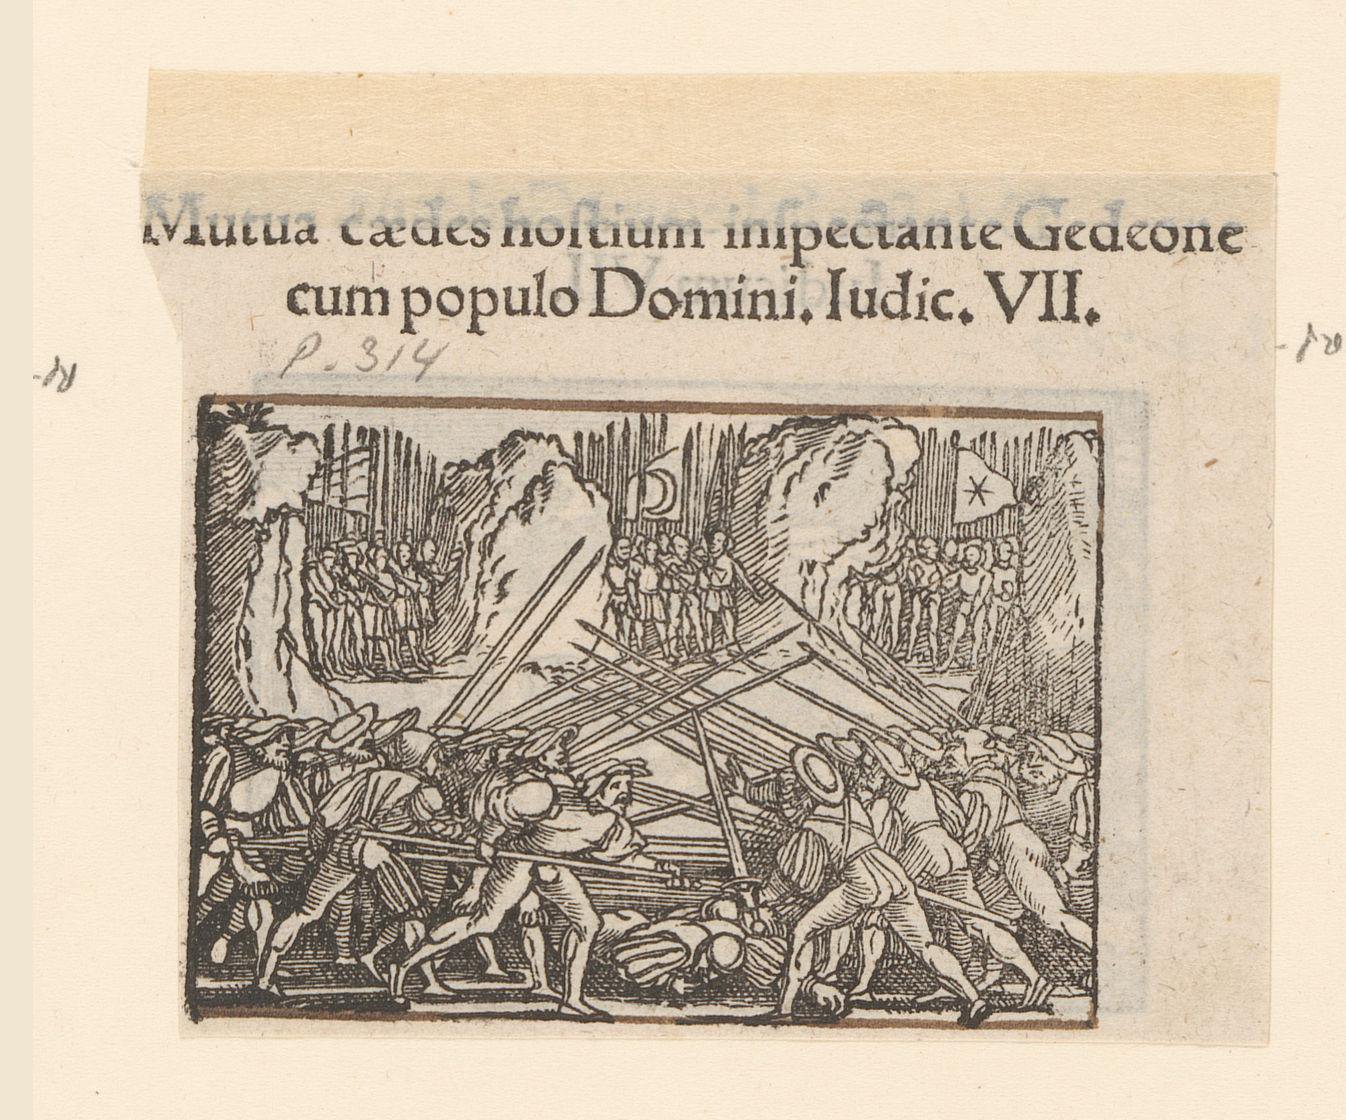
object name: book illustration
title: Gideons manschappen verslaan de Midianieten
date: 1530-1533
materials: paper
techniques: woodcut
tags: gideon and his army attack the midianites (judges 7:9-25)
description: Prent afkomstig uit: Biblicae historiae. Frankfurt am Main: Egenloph, 1539.